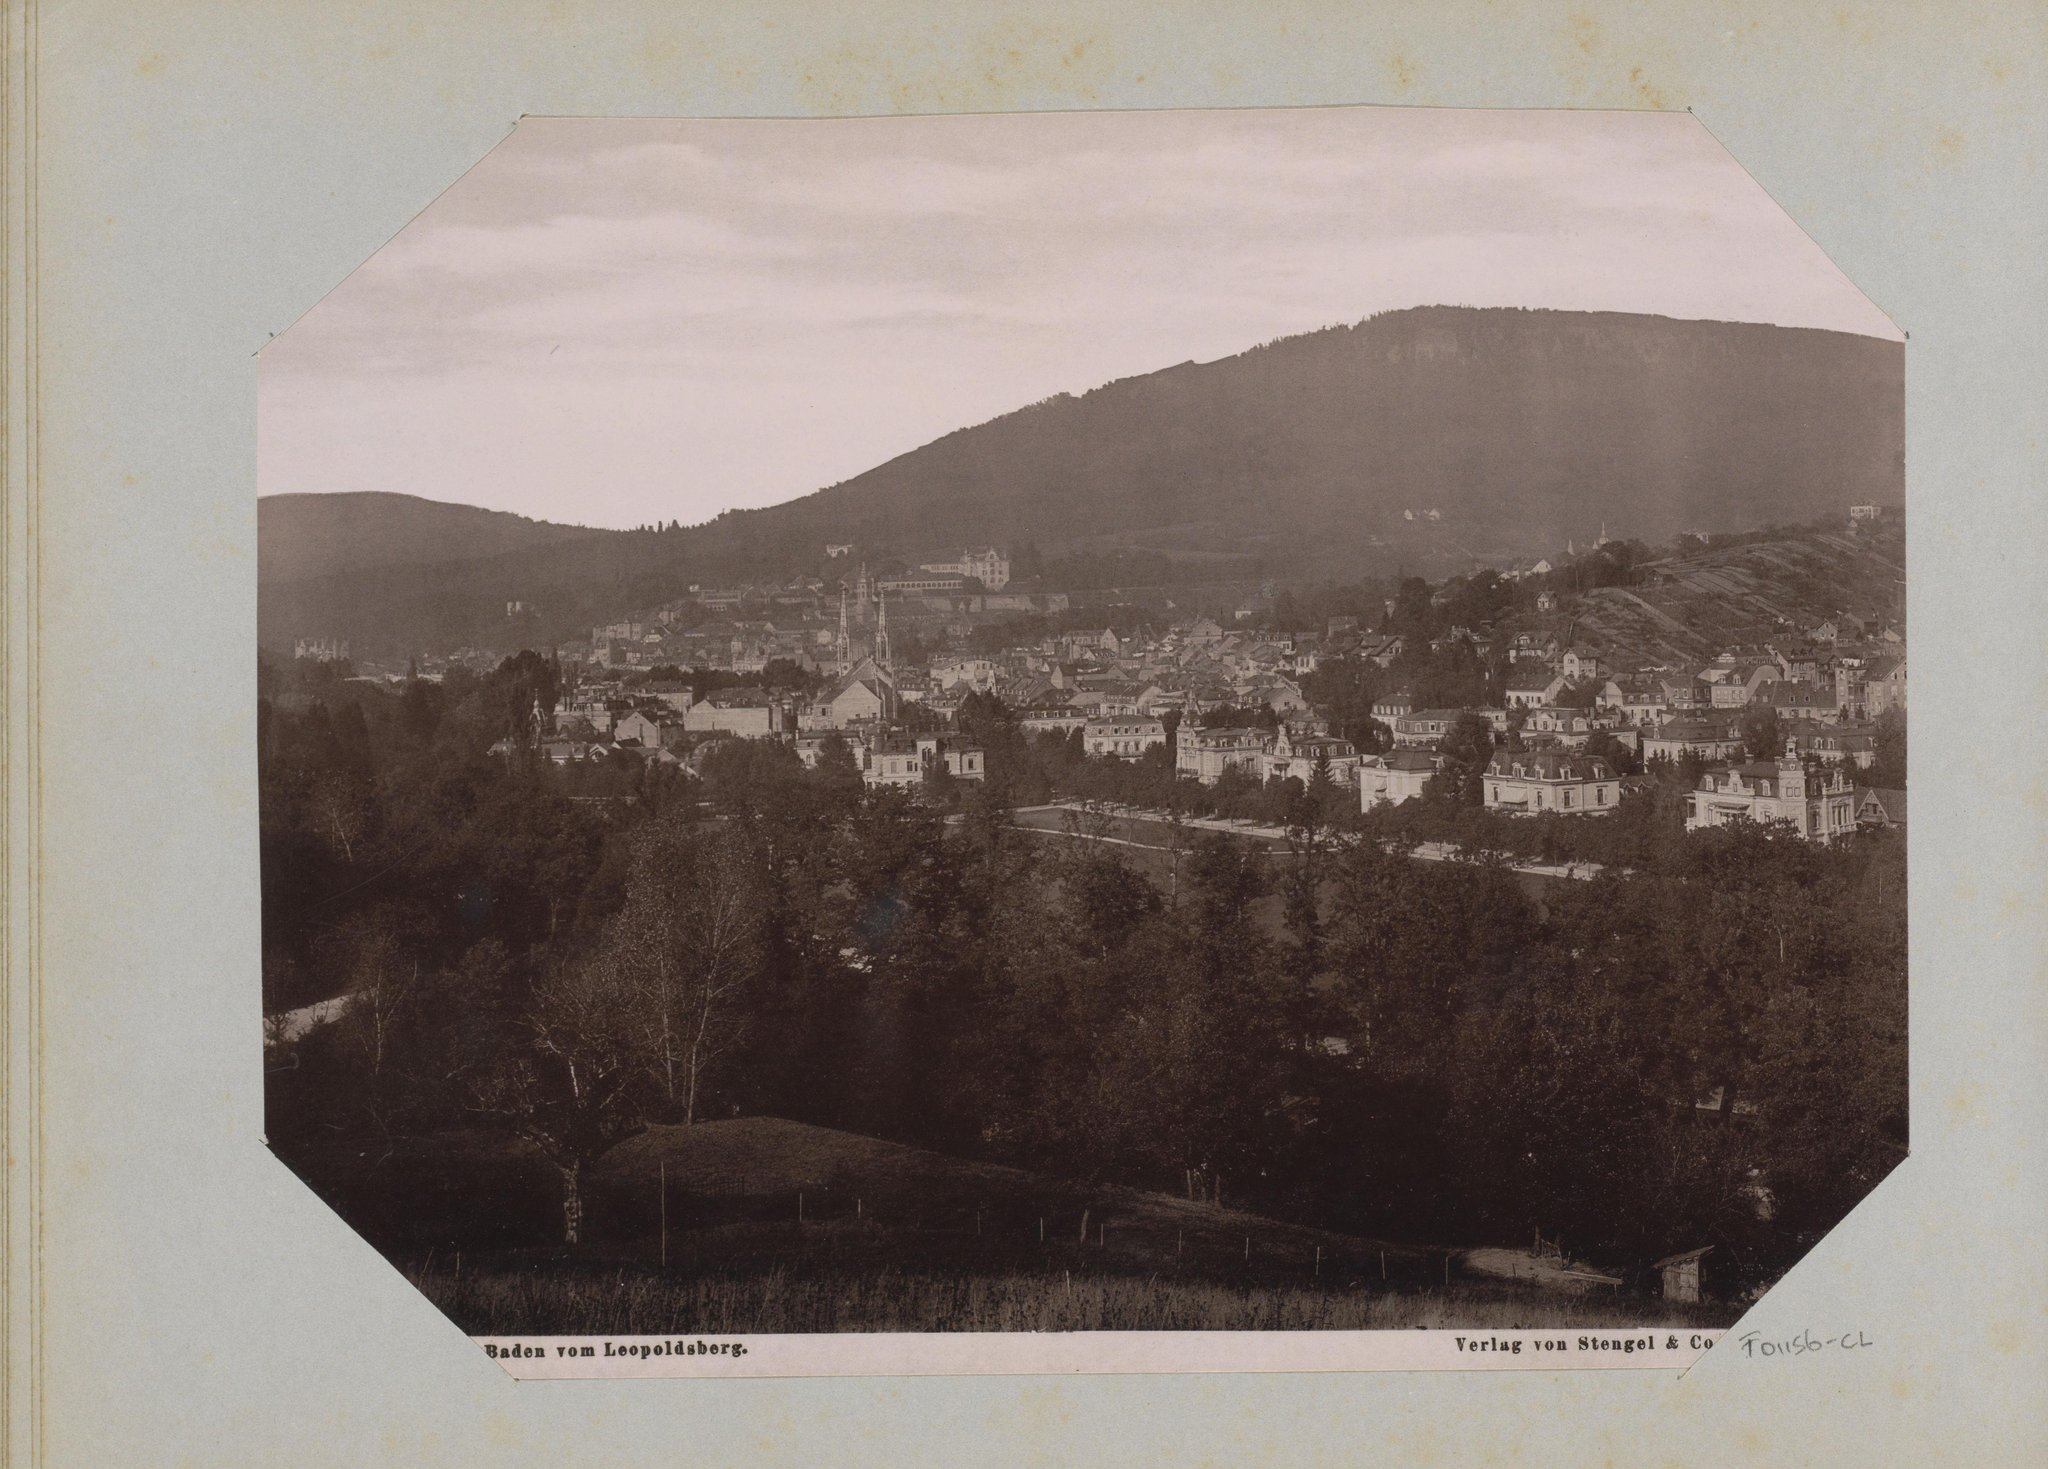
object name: album leaf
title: Baden-Baden gezien vanaf de Leopoldsberg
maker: Anonymous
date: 1897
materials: paper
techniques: albumen print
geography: dresden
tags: city-view in general; 'veduta'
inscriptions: inscription: ‘Baden-Baden vom Leopoldsberg/ Verlag von Stengel & Co. Dresden 1604’, inscription: ‘Stengel&Co./ 1897/ Dresden’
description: Deze prent maakt deel uit van een album.